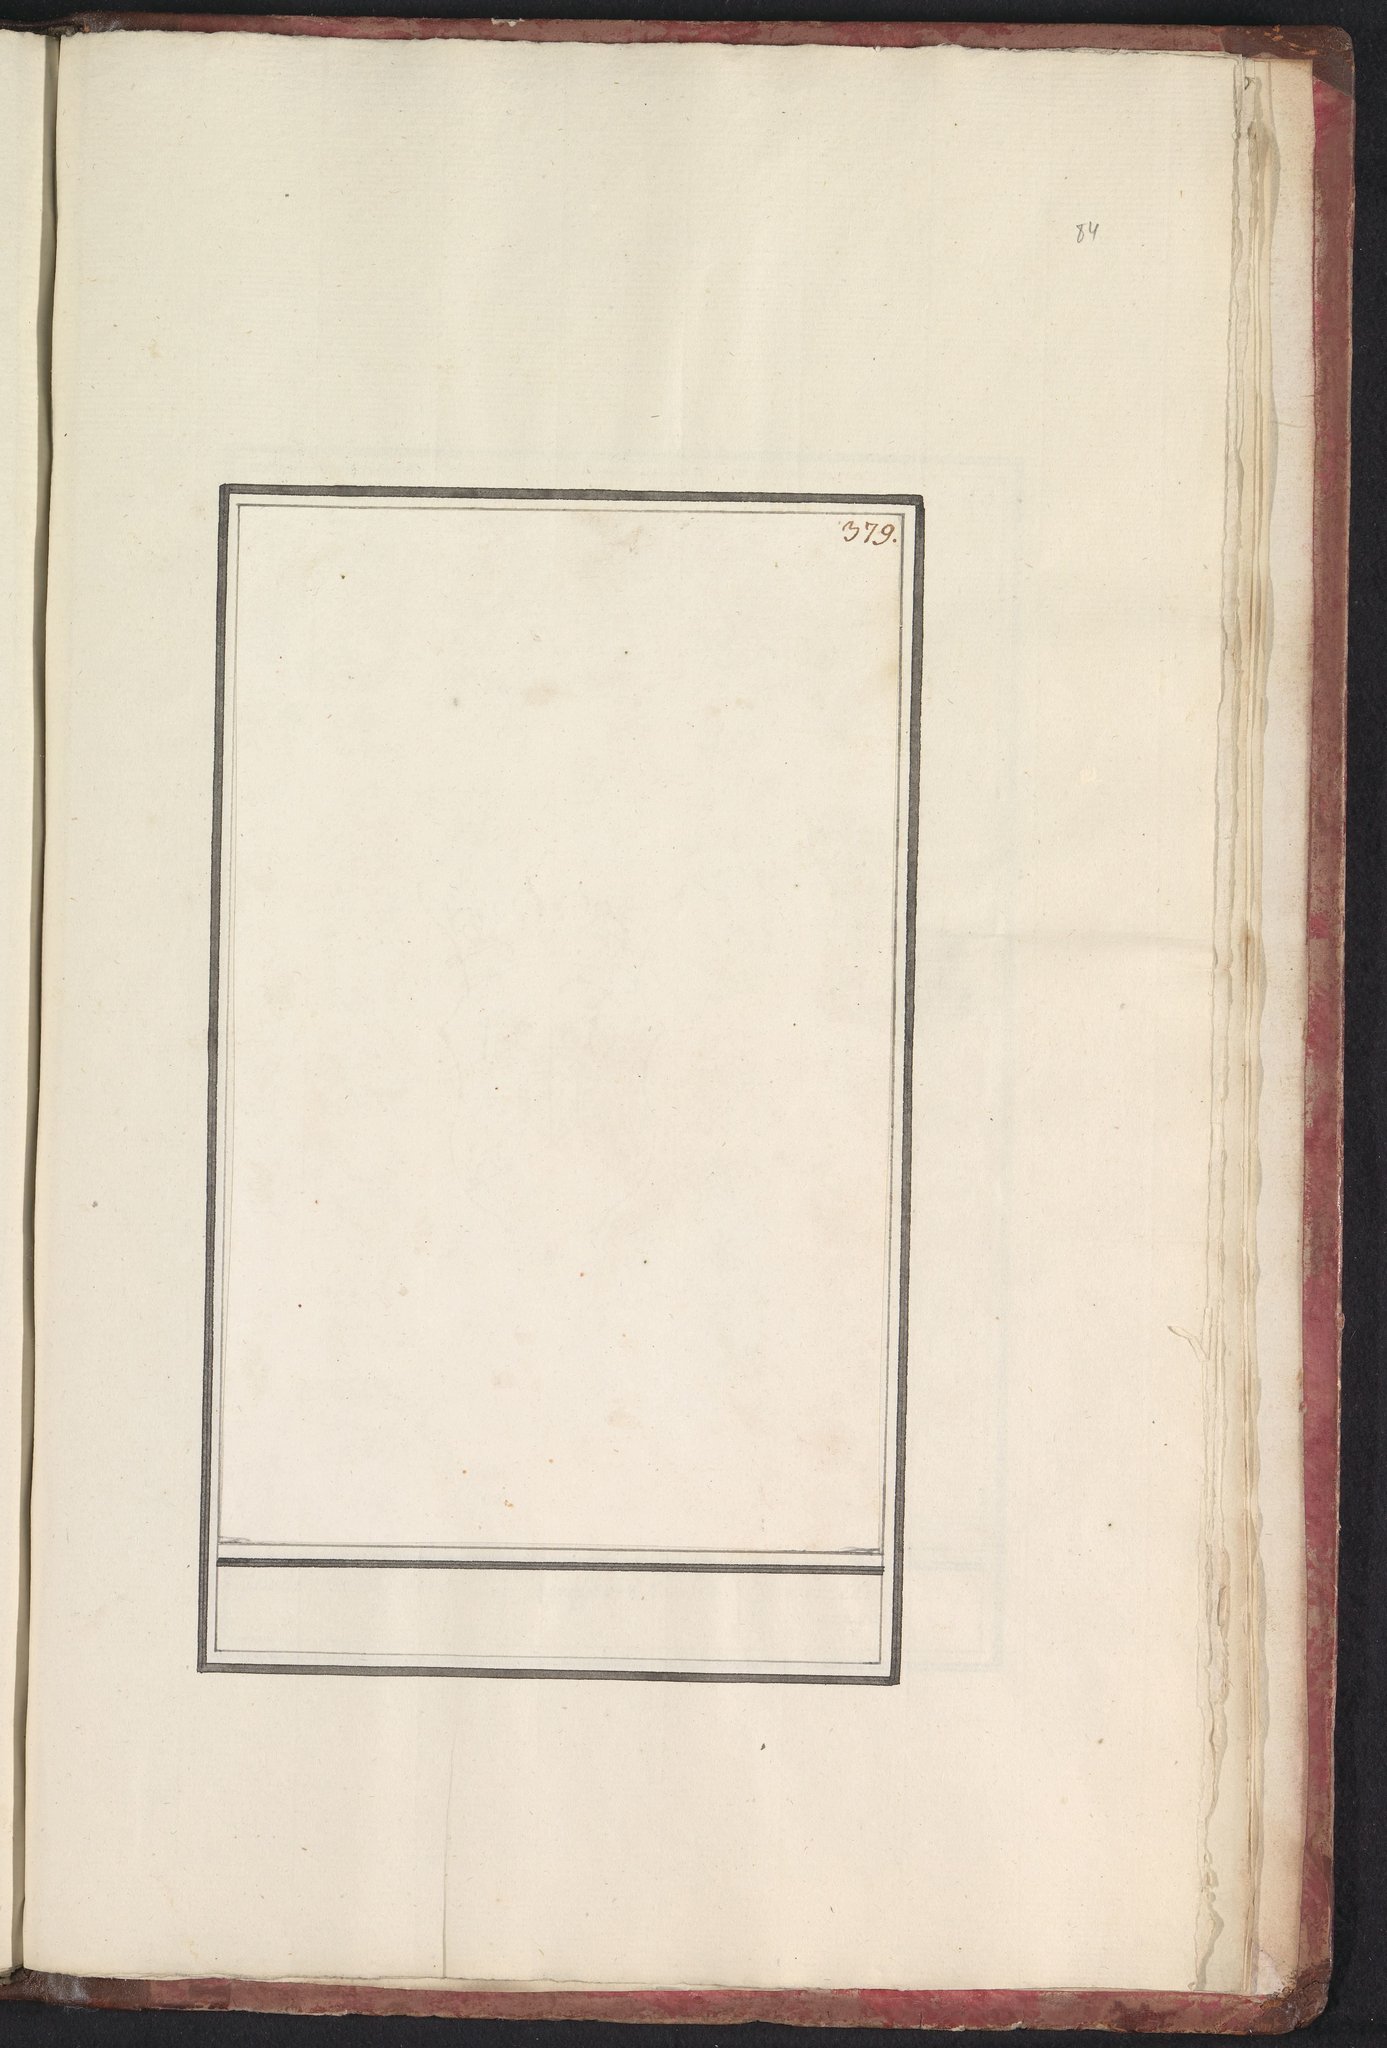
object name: drawing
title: Omlijsting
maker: Anonymous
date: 1809-1814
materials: paper, pencil, watercolor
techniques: brush, pen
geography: southern netherlands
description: Lege omlijsting. Rechtsboven genummerd: 379. Onderdeel van het vierde album met tekeningen van bloemen en paddestoelen. Elfde van twaalf albums met tekeningen van dieren, vogels en planten bekend rond 1600, gemaakt in opdracht van keizer Rudolf II. Met toelichting in Nederlands, Latijn en Frans.